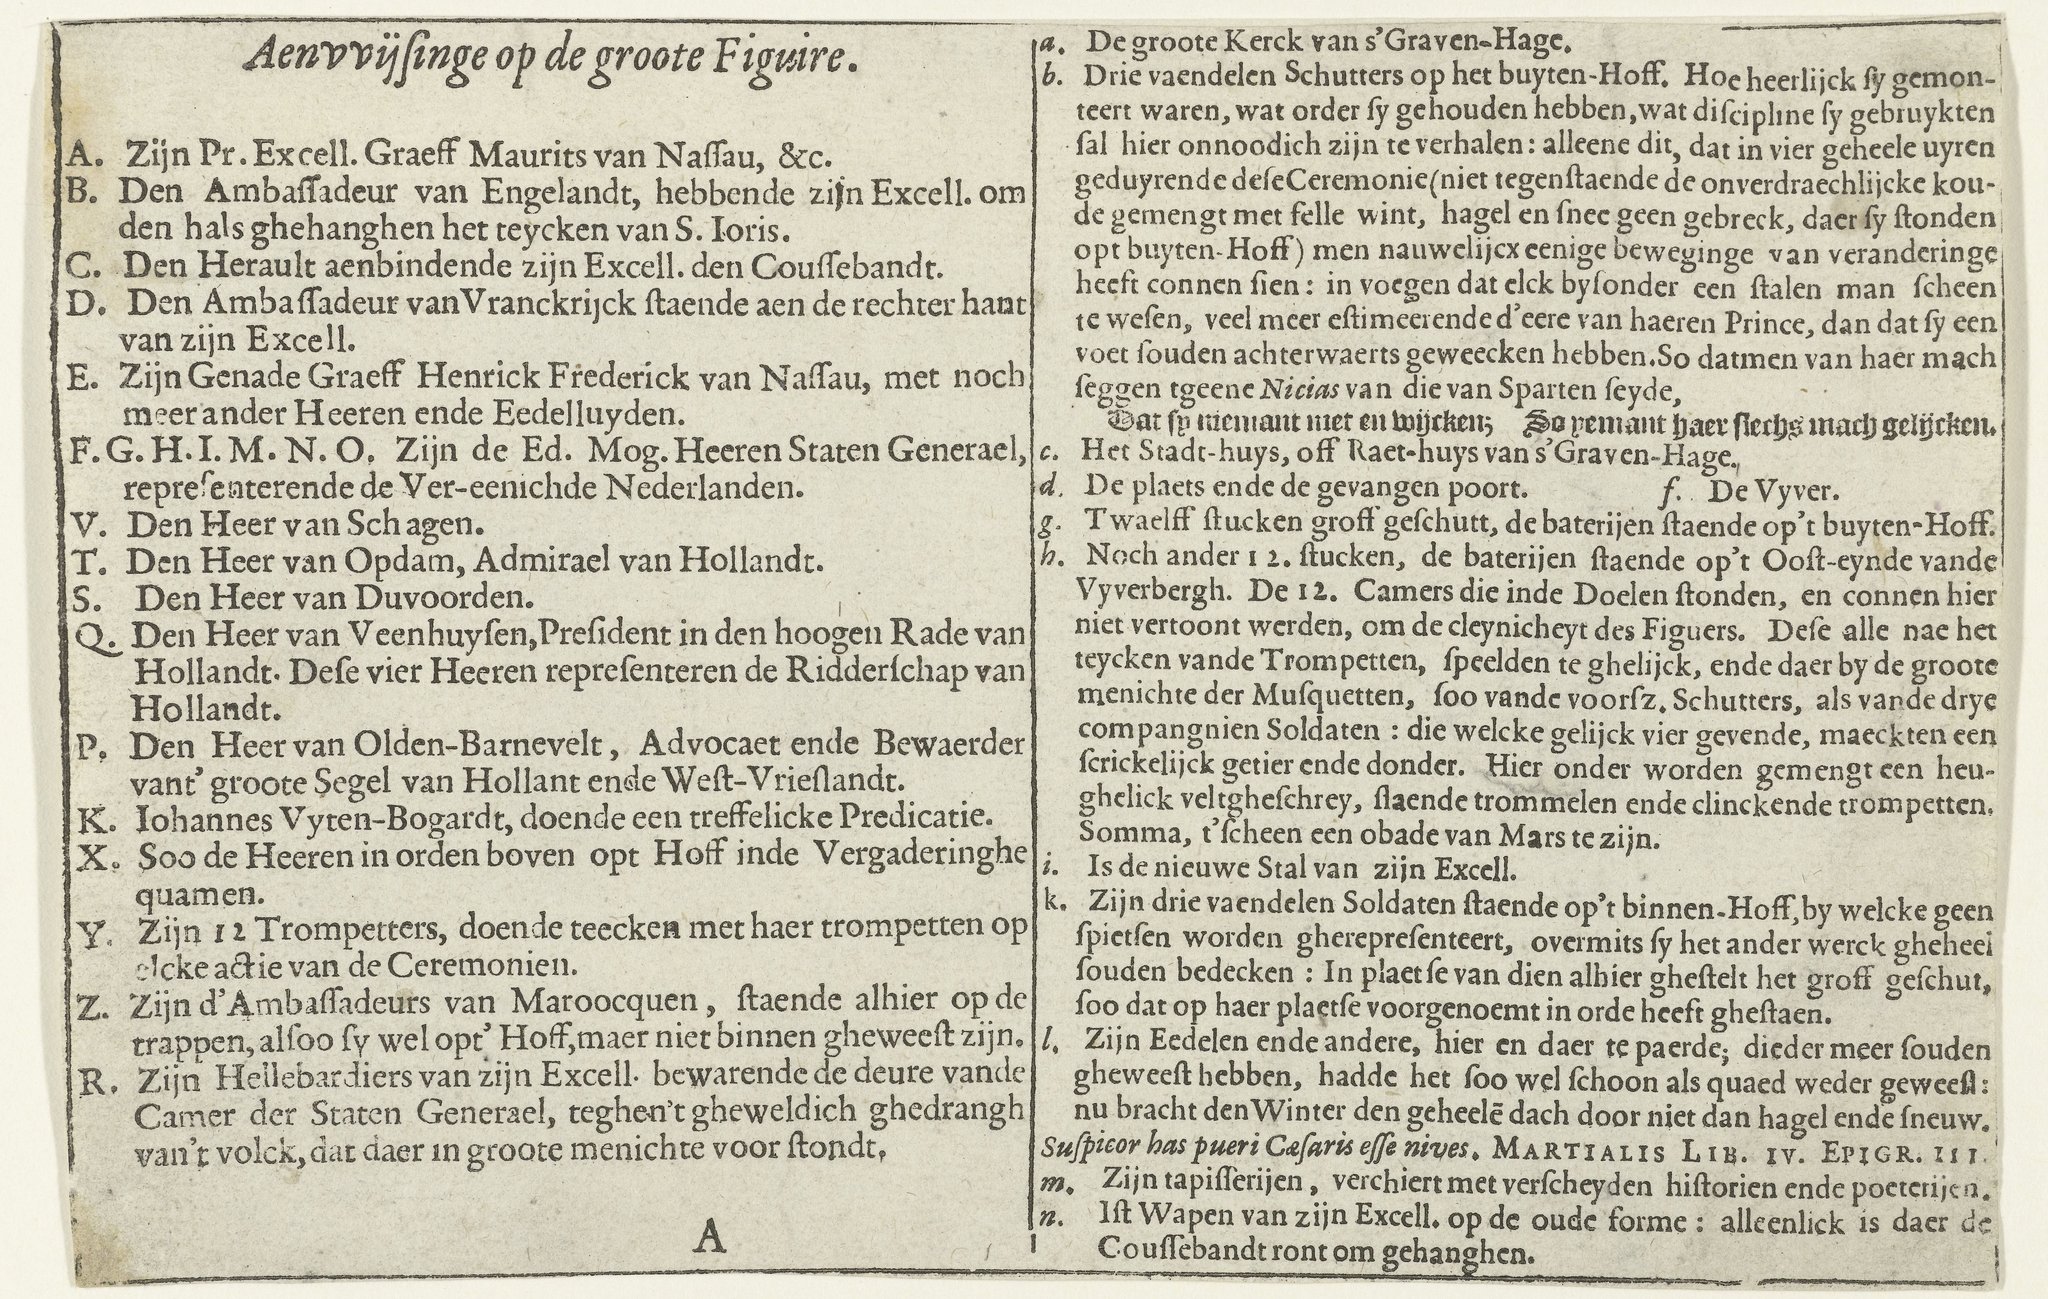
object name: print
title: Aenwijsinge op de groote Figuire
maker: simon frisius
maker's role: print maker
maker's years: 1570-1628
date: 1613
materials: paper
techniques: letterpress printing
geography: northern netherlands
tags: maurice (prince of orange), clothing (~ knighting ceremony), knighthood order (garter)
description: Legenda A-R en a-n in twee kolommen in het Nederlands. Onderdeel van de prent van de investituur van Maurits met de Orde van de Kousenband, 4 februari 1613.